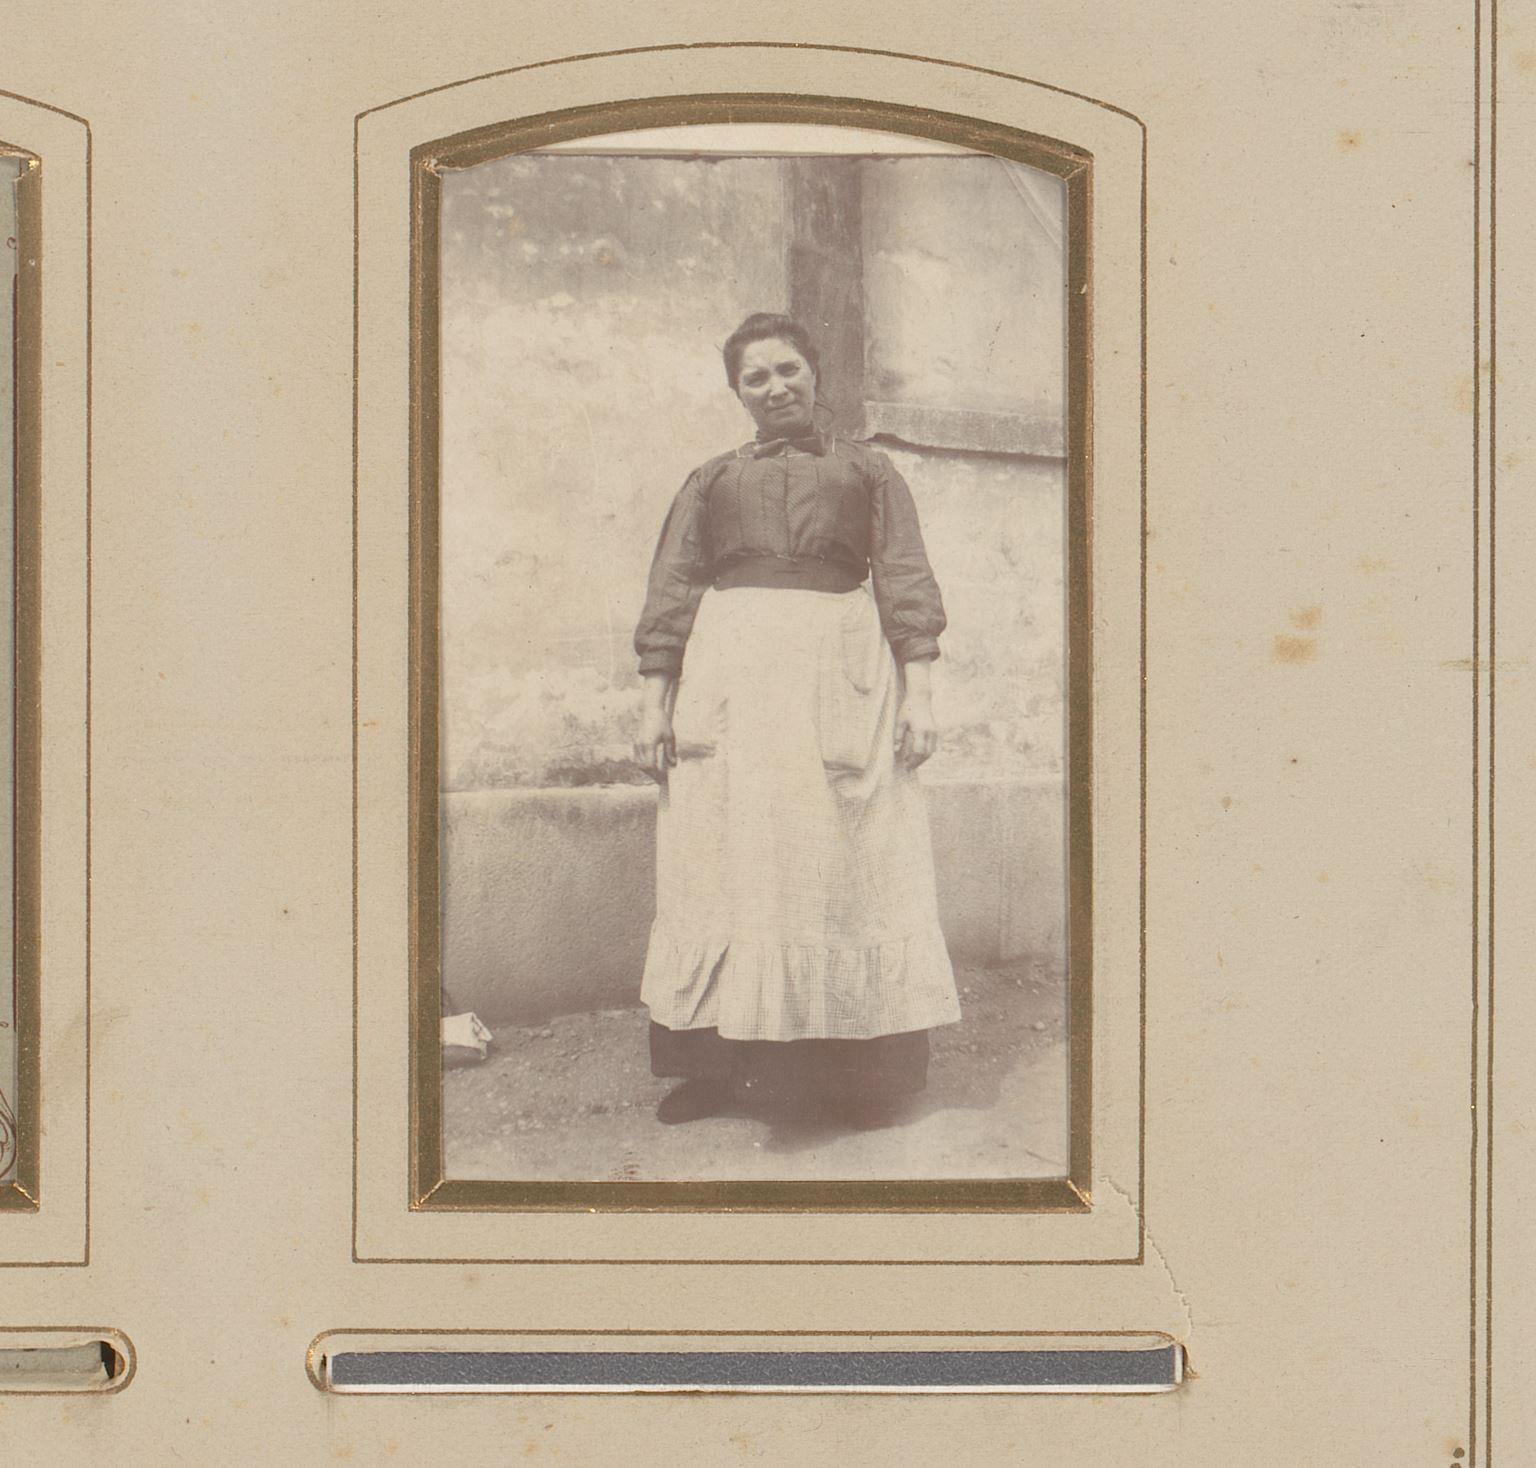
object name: photograph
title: Portret van een vrouw met schort, staand voor een gebouw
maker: Anonymous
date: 1880-1930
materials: cardboard, photographic support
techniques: gelatin silver print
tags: historical persons - bb - woman, apron, edifice, e.g.: public building, department store